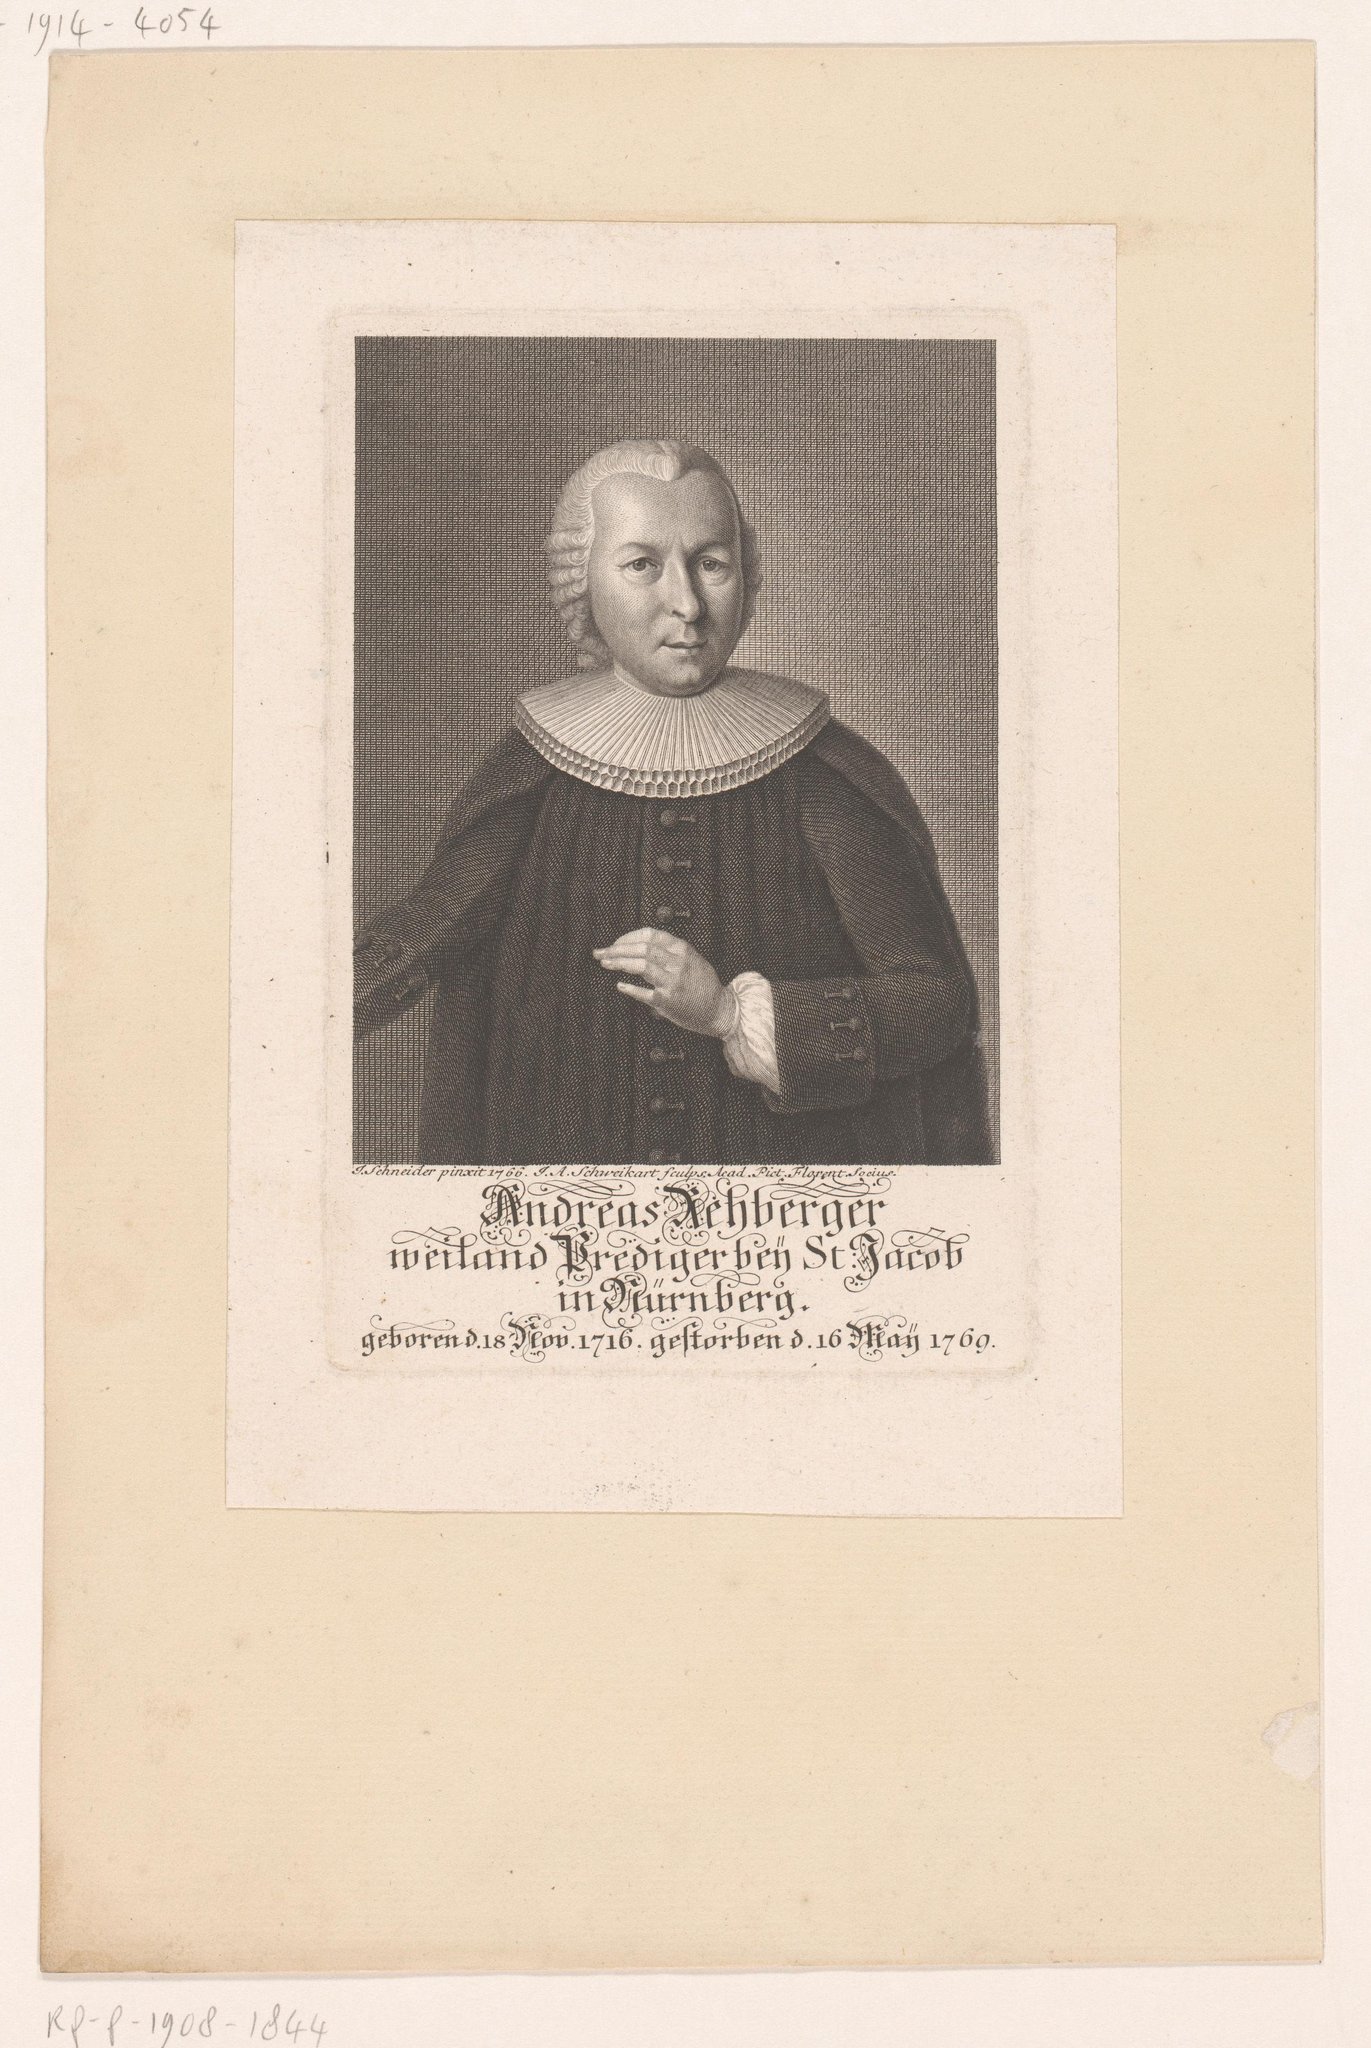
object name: print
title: Portret van Andreas Rehberger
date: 1769-1787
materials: paper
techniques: engraving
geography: florence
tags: theologian, historical persons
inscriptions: collector's mark: Lugt 2228